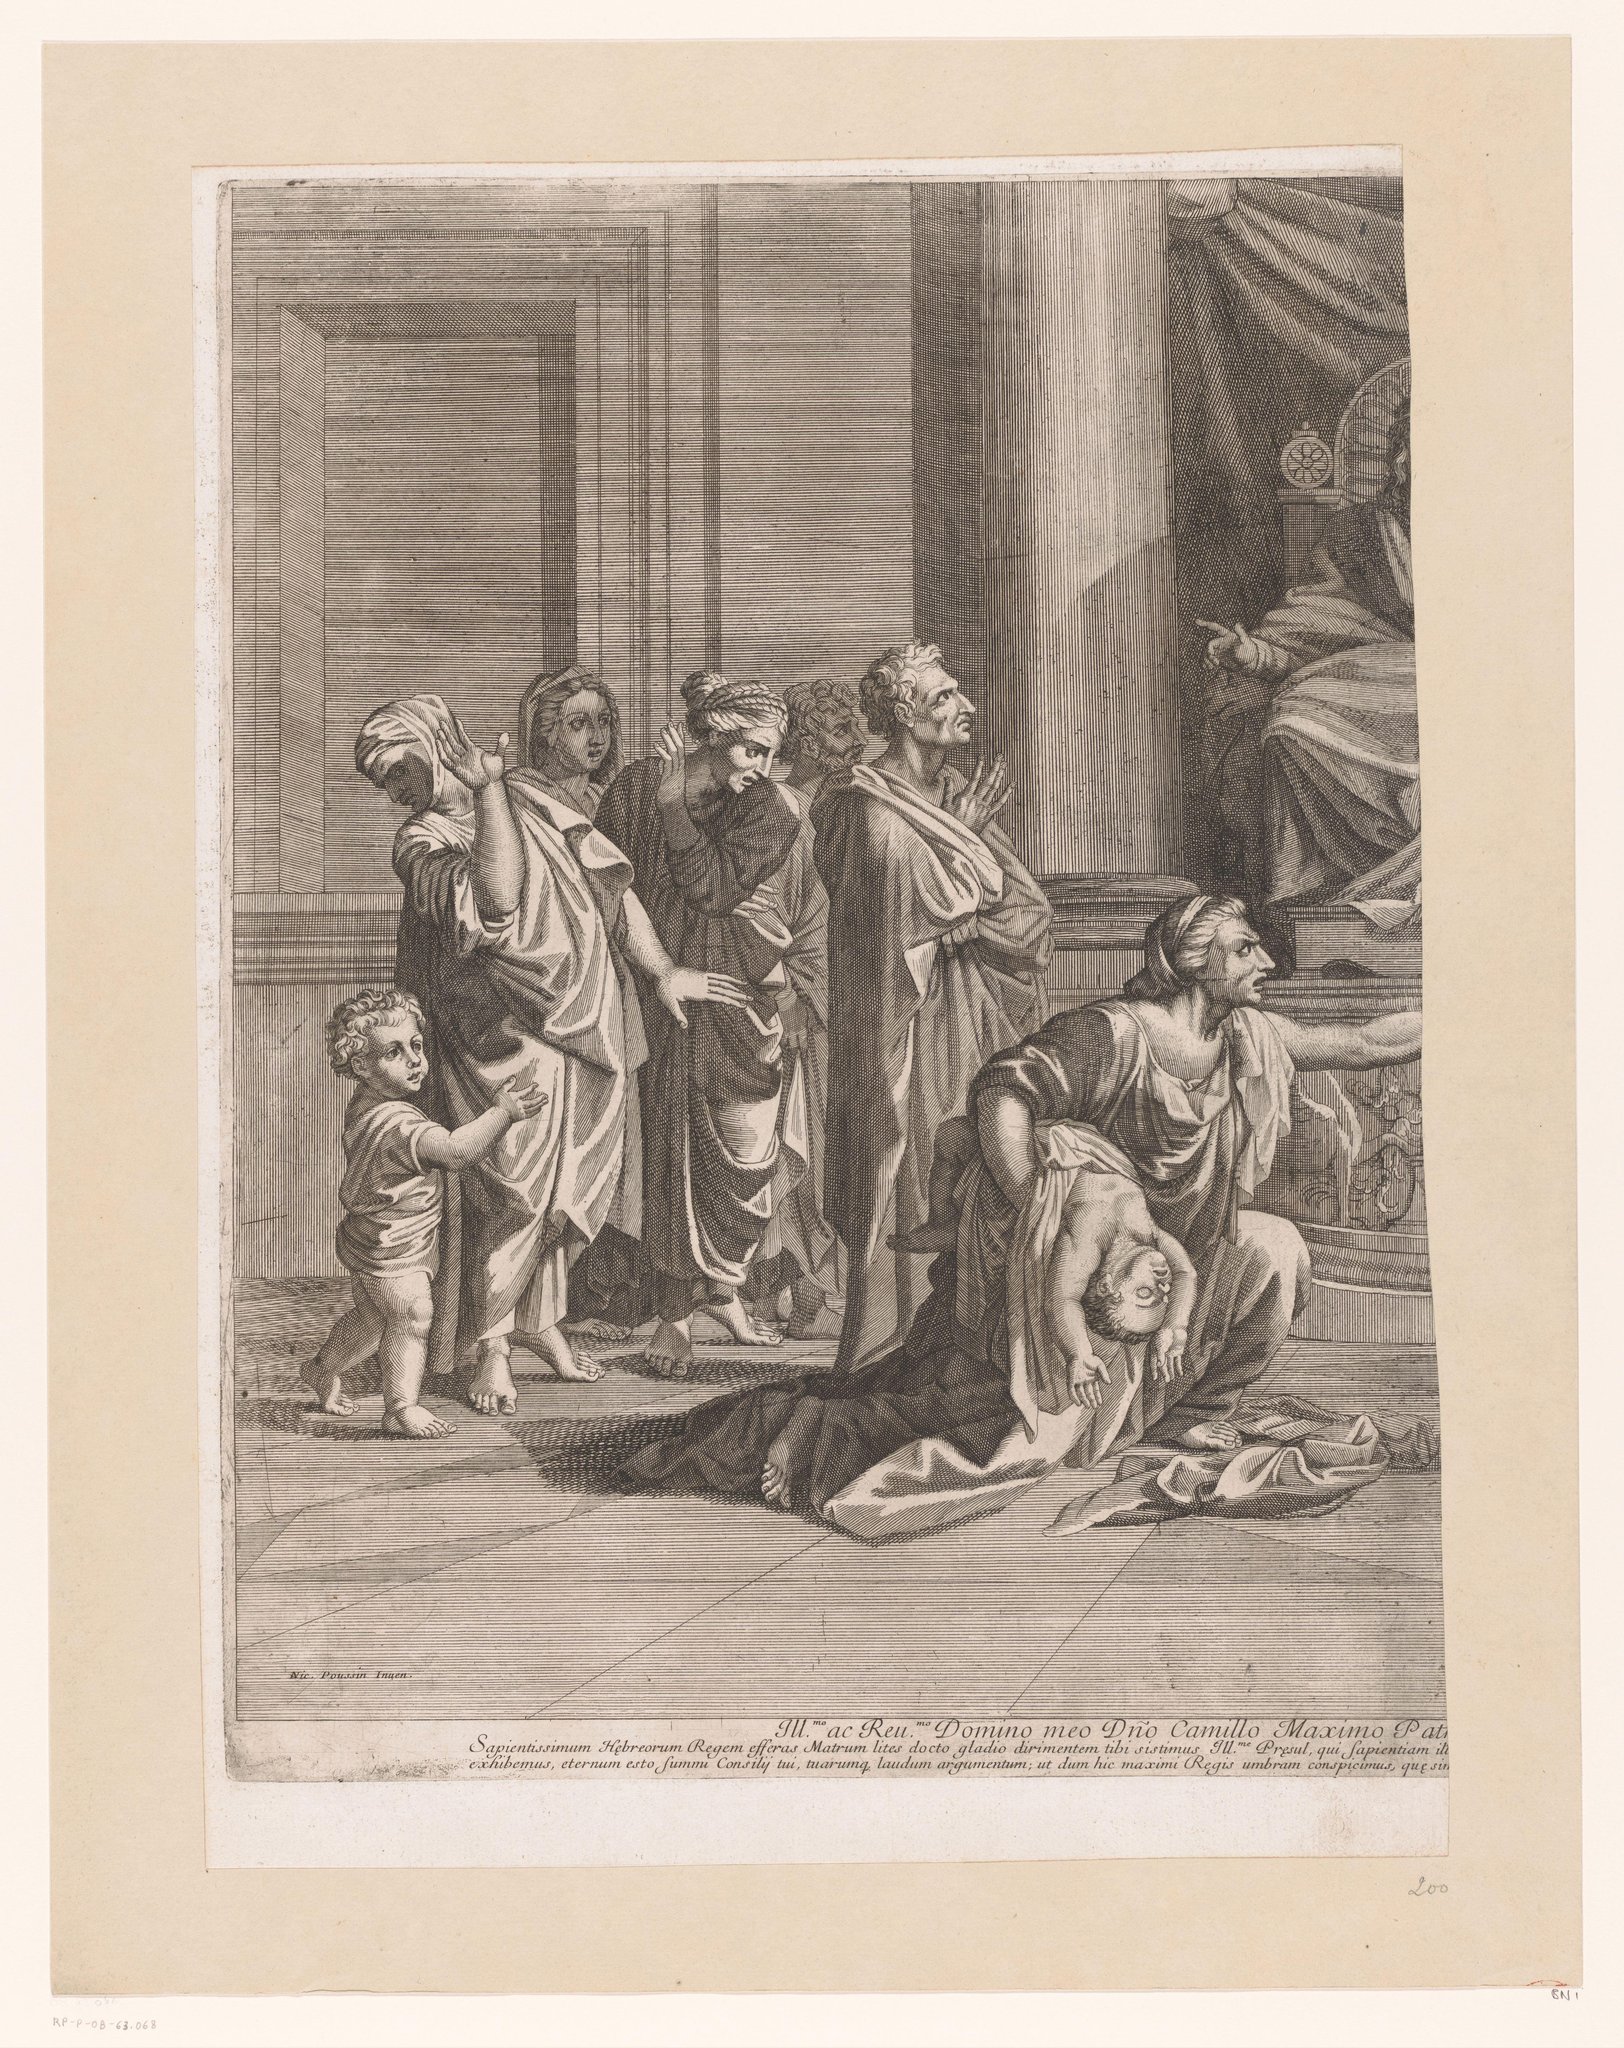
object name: print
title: Oordeel van Salomon (linkerdeel)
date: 1625-1679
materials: paper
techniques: engraving, etching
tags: solomon gives verdict; he commands a soldier to divide the living child in two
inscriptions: collector's mark: Lugt 240